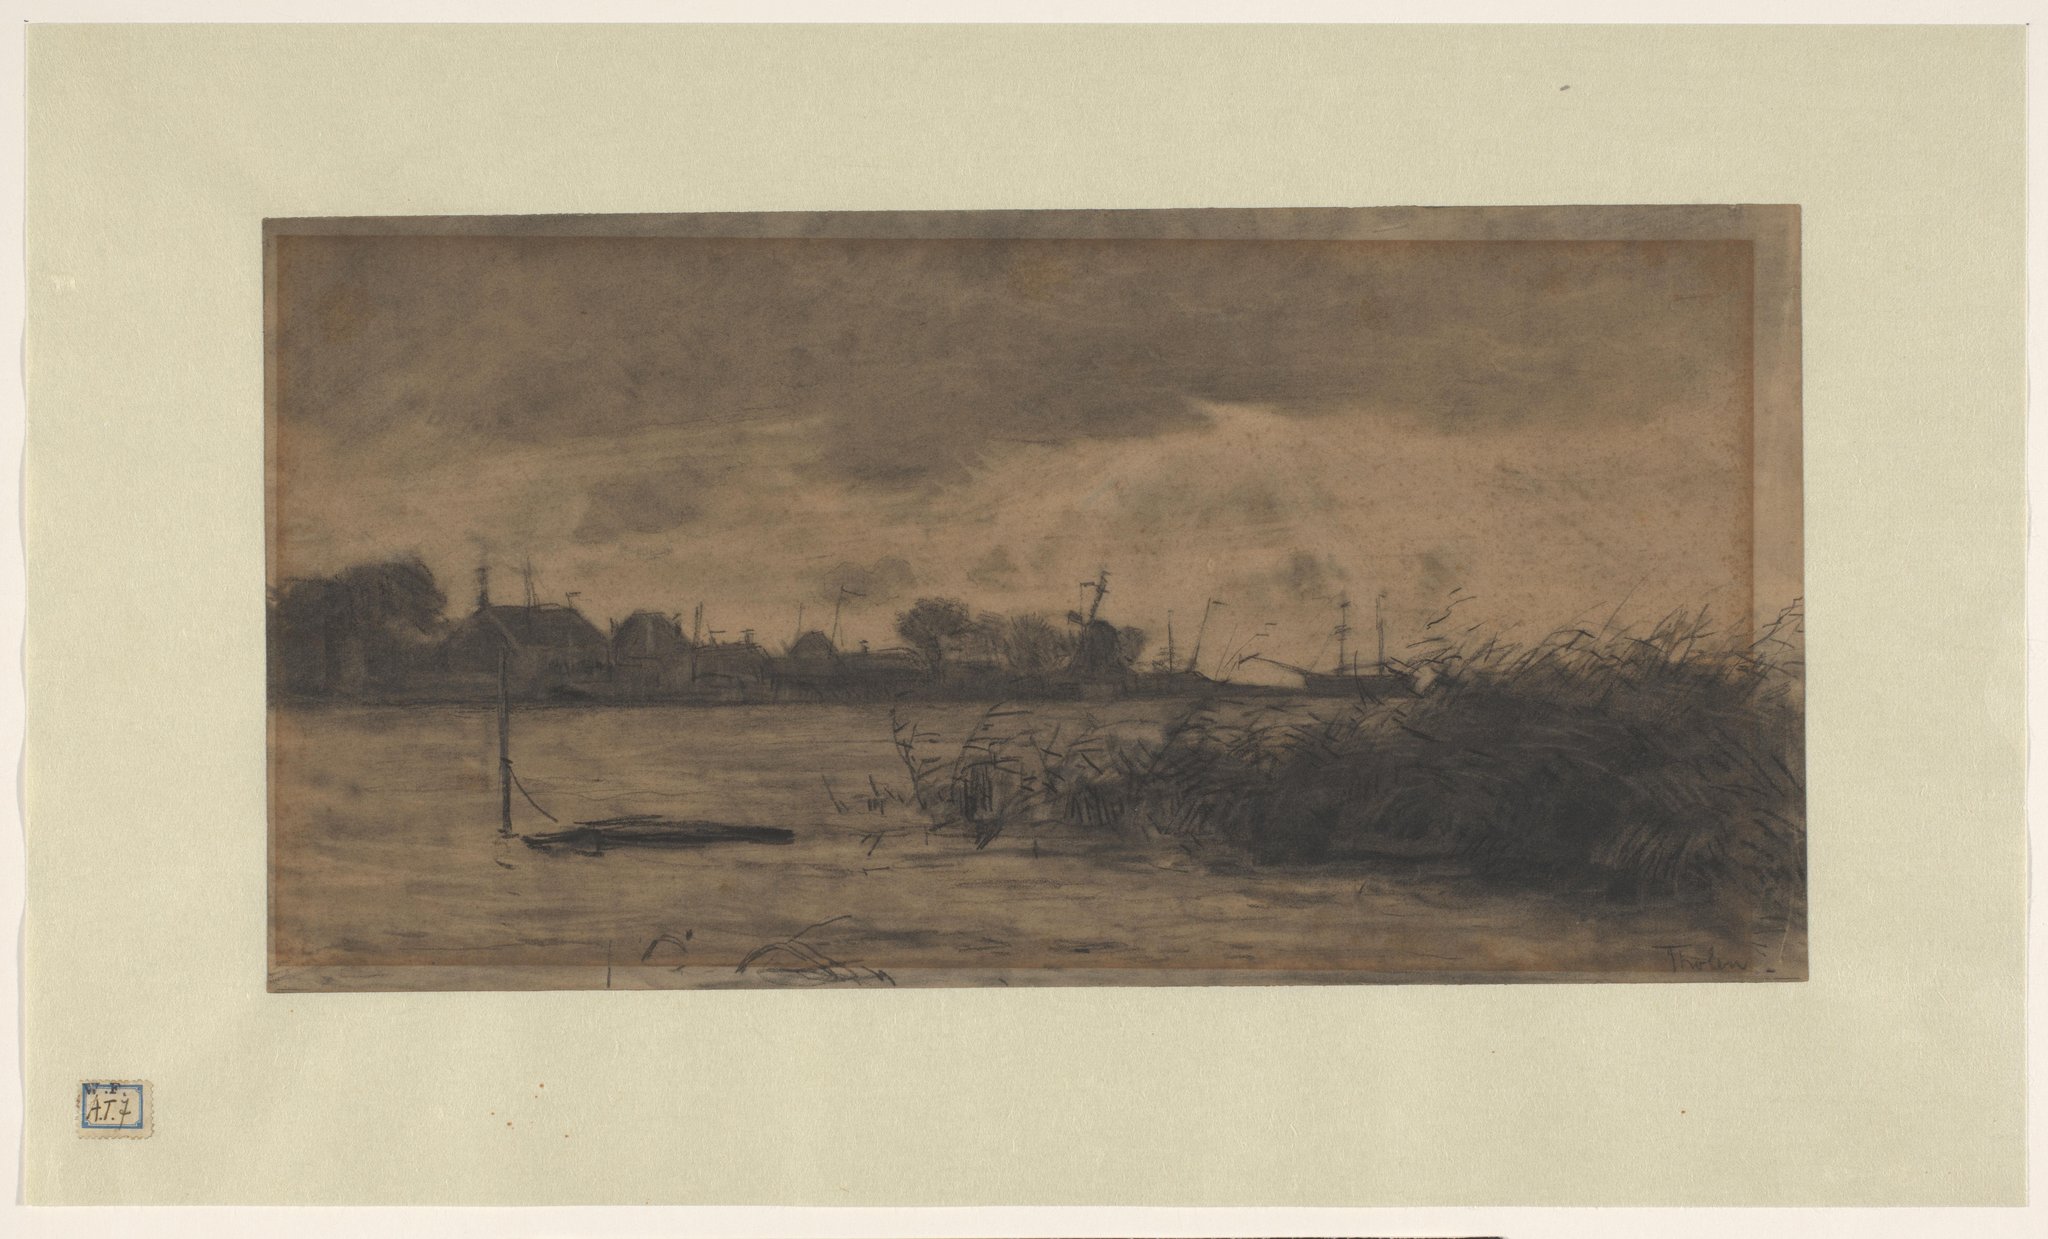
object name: drawing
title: Gezicht op een rivier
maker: willem bastiaan tholen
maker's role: draughtsman, painter, print maker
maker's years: 1860-1931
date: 1870-1931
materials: chalk, paper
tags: river